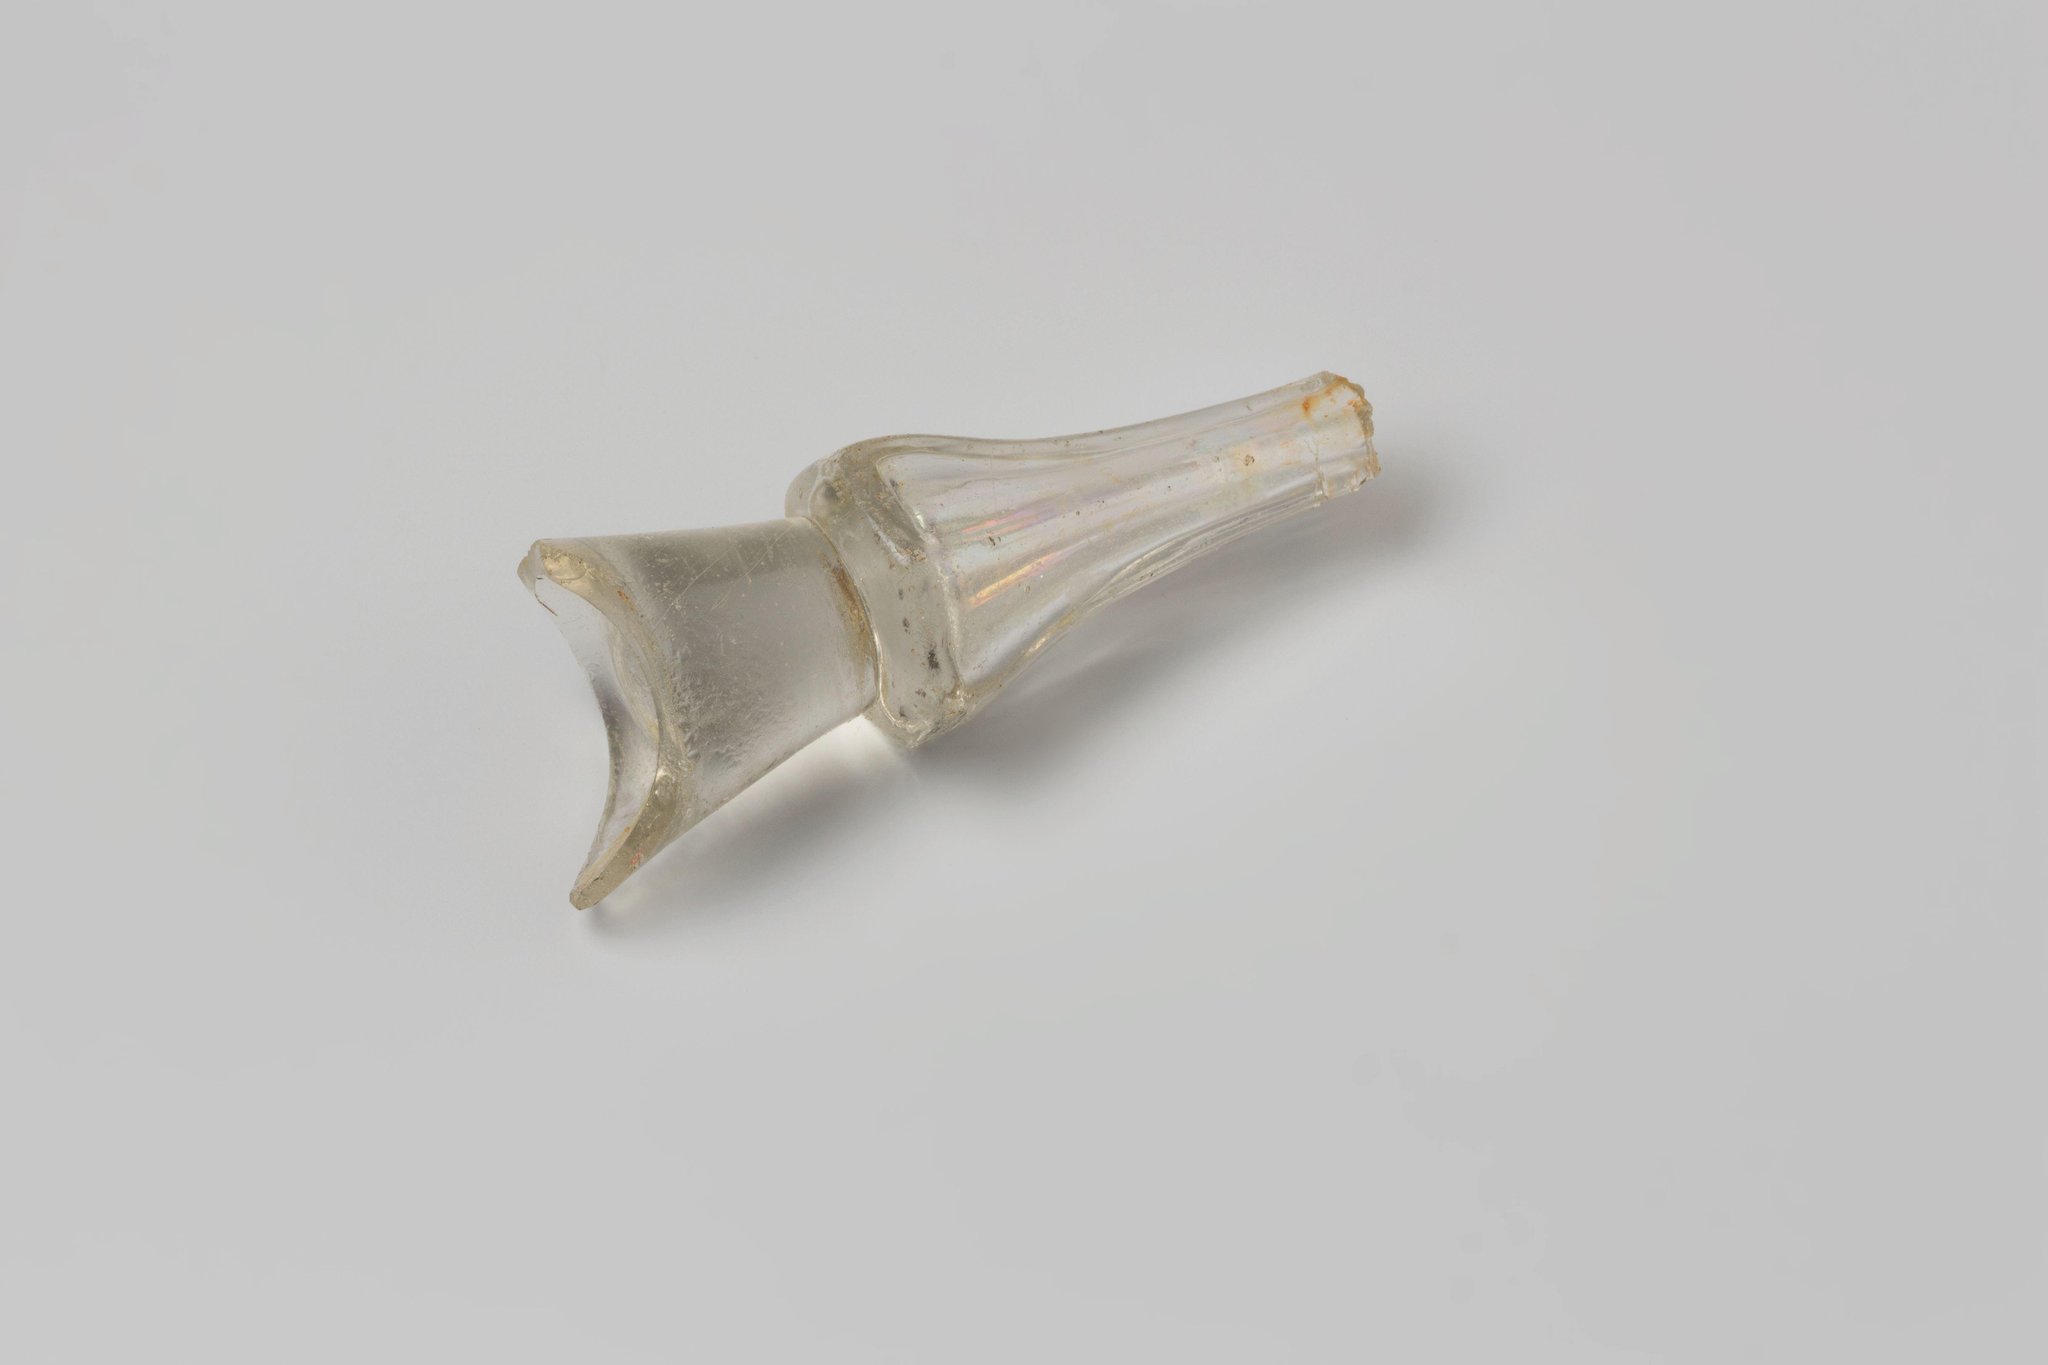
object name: drinking glass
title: Fragment gefacetteerde steel van een fluitglas uit het wrak van de Oost-Indiëvaarder Hollandia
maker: Anonymous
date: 1700-1743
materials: glass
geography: netherlands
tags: verenigde oostindische compagnie, hollandia (schip), annet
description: Glass, stem glass, steel, faceted; fragment, hexagonal faceted, tapering downward, hollow core, bevelled upper end with base of bowl, conically everted.